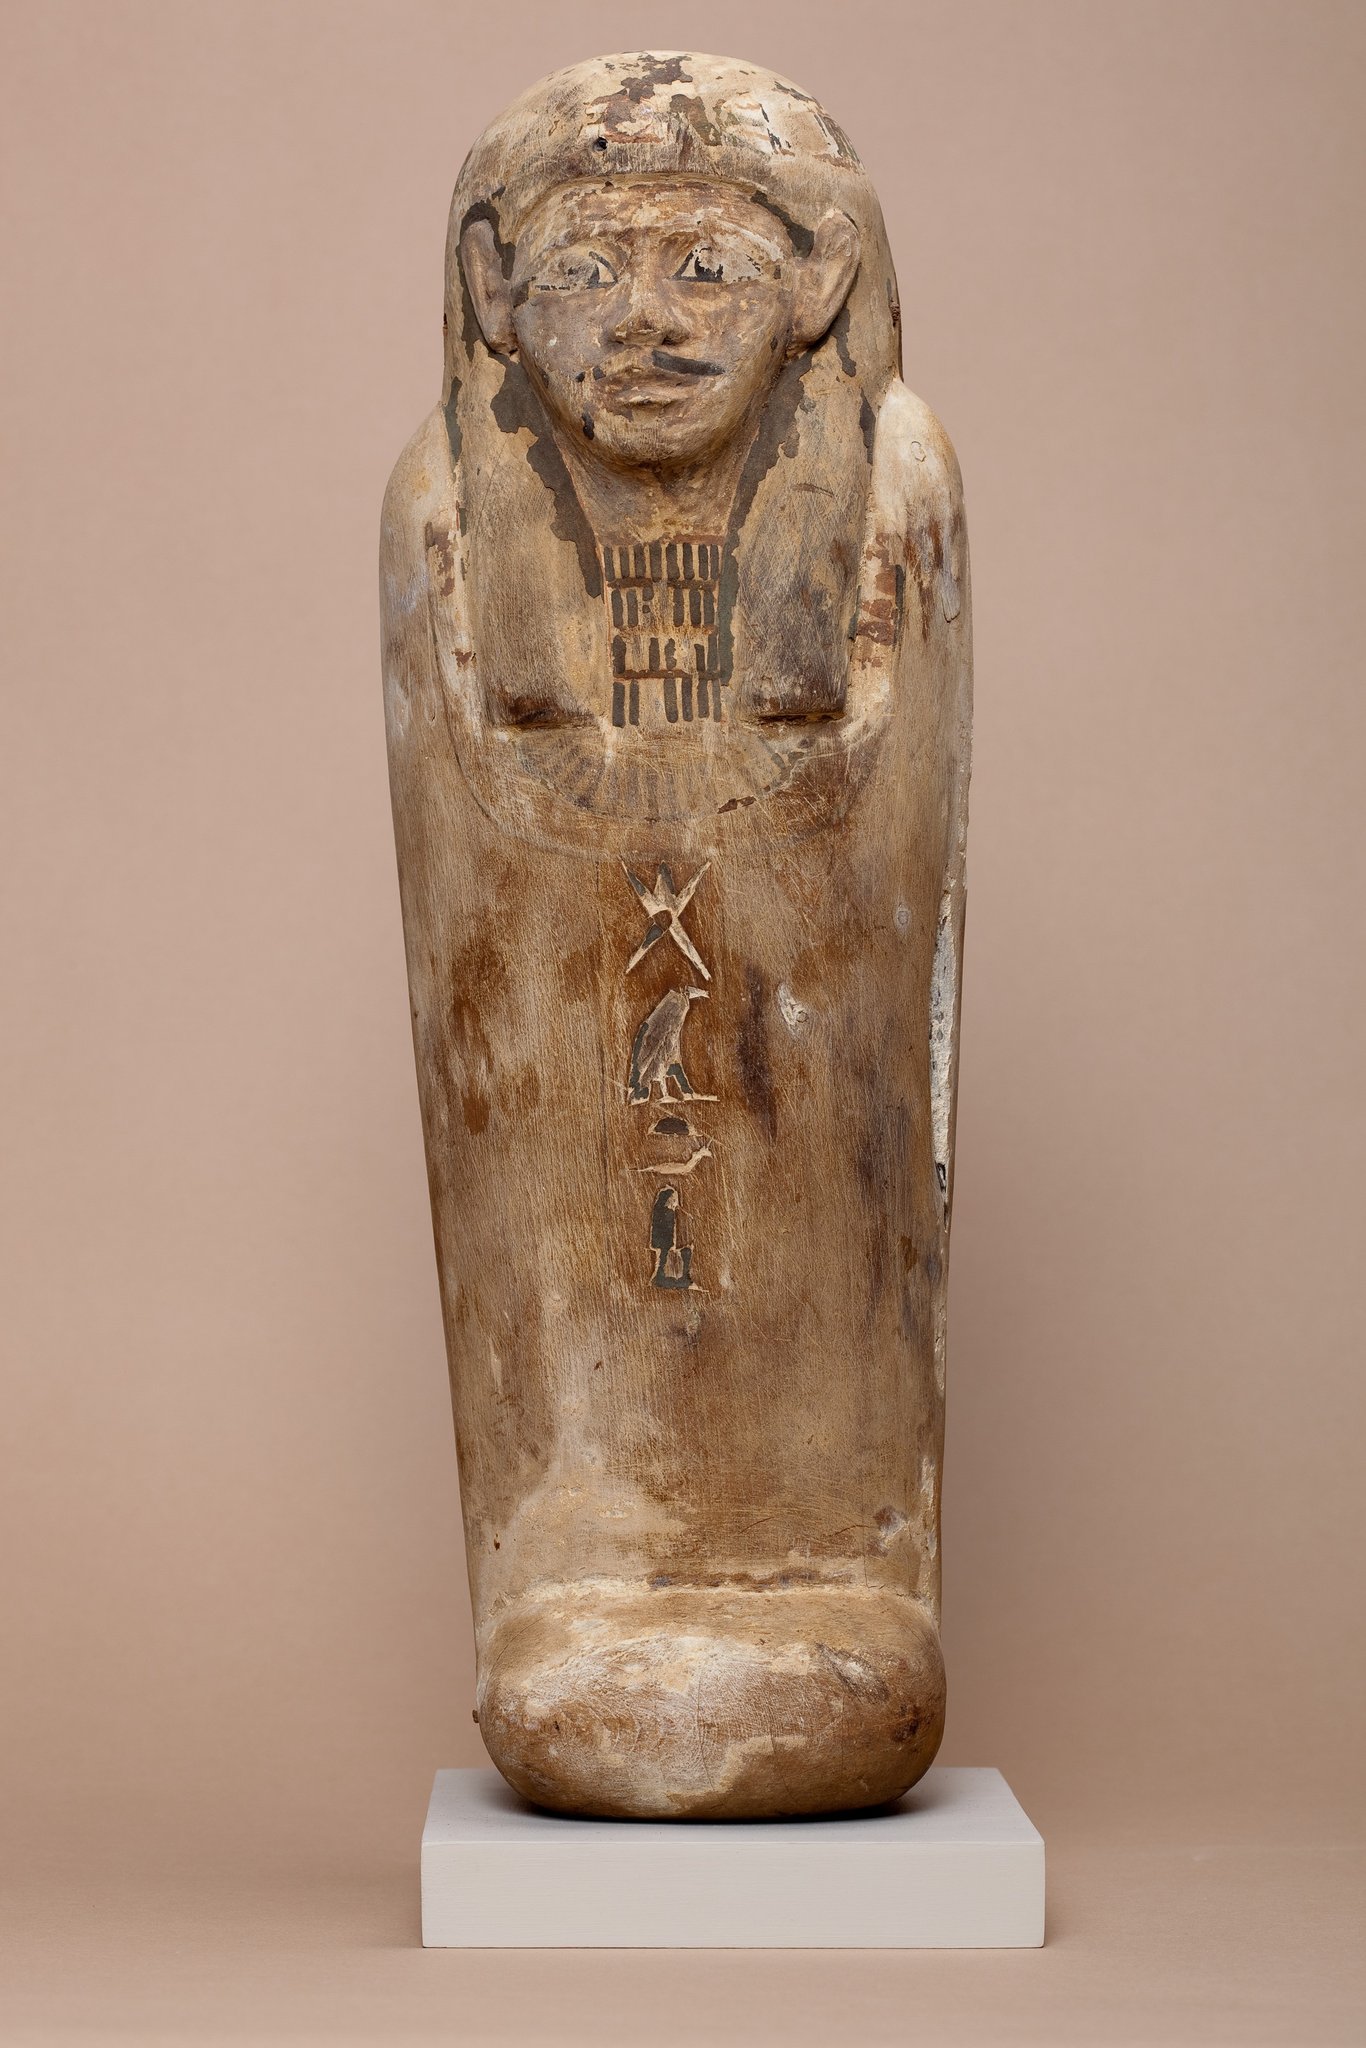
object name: canopic jar, duamutef, coffin form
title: Anthropoid-coffin-form canopic container inscribed with the name of Duamutef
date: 1981-1802 BCE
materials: paint, wood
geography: egypt